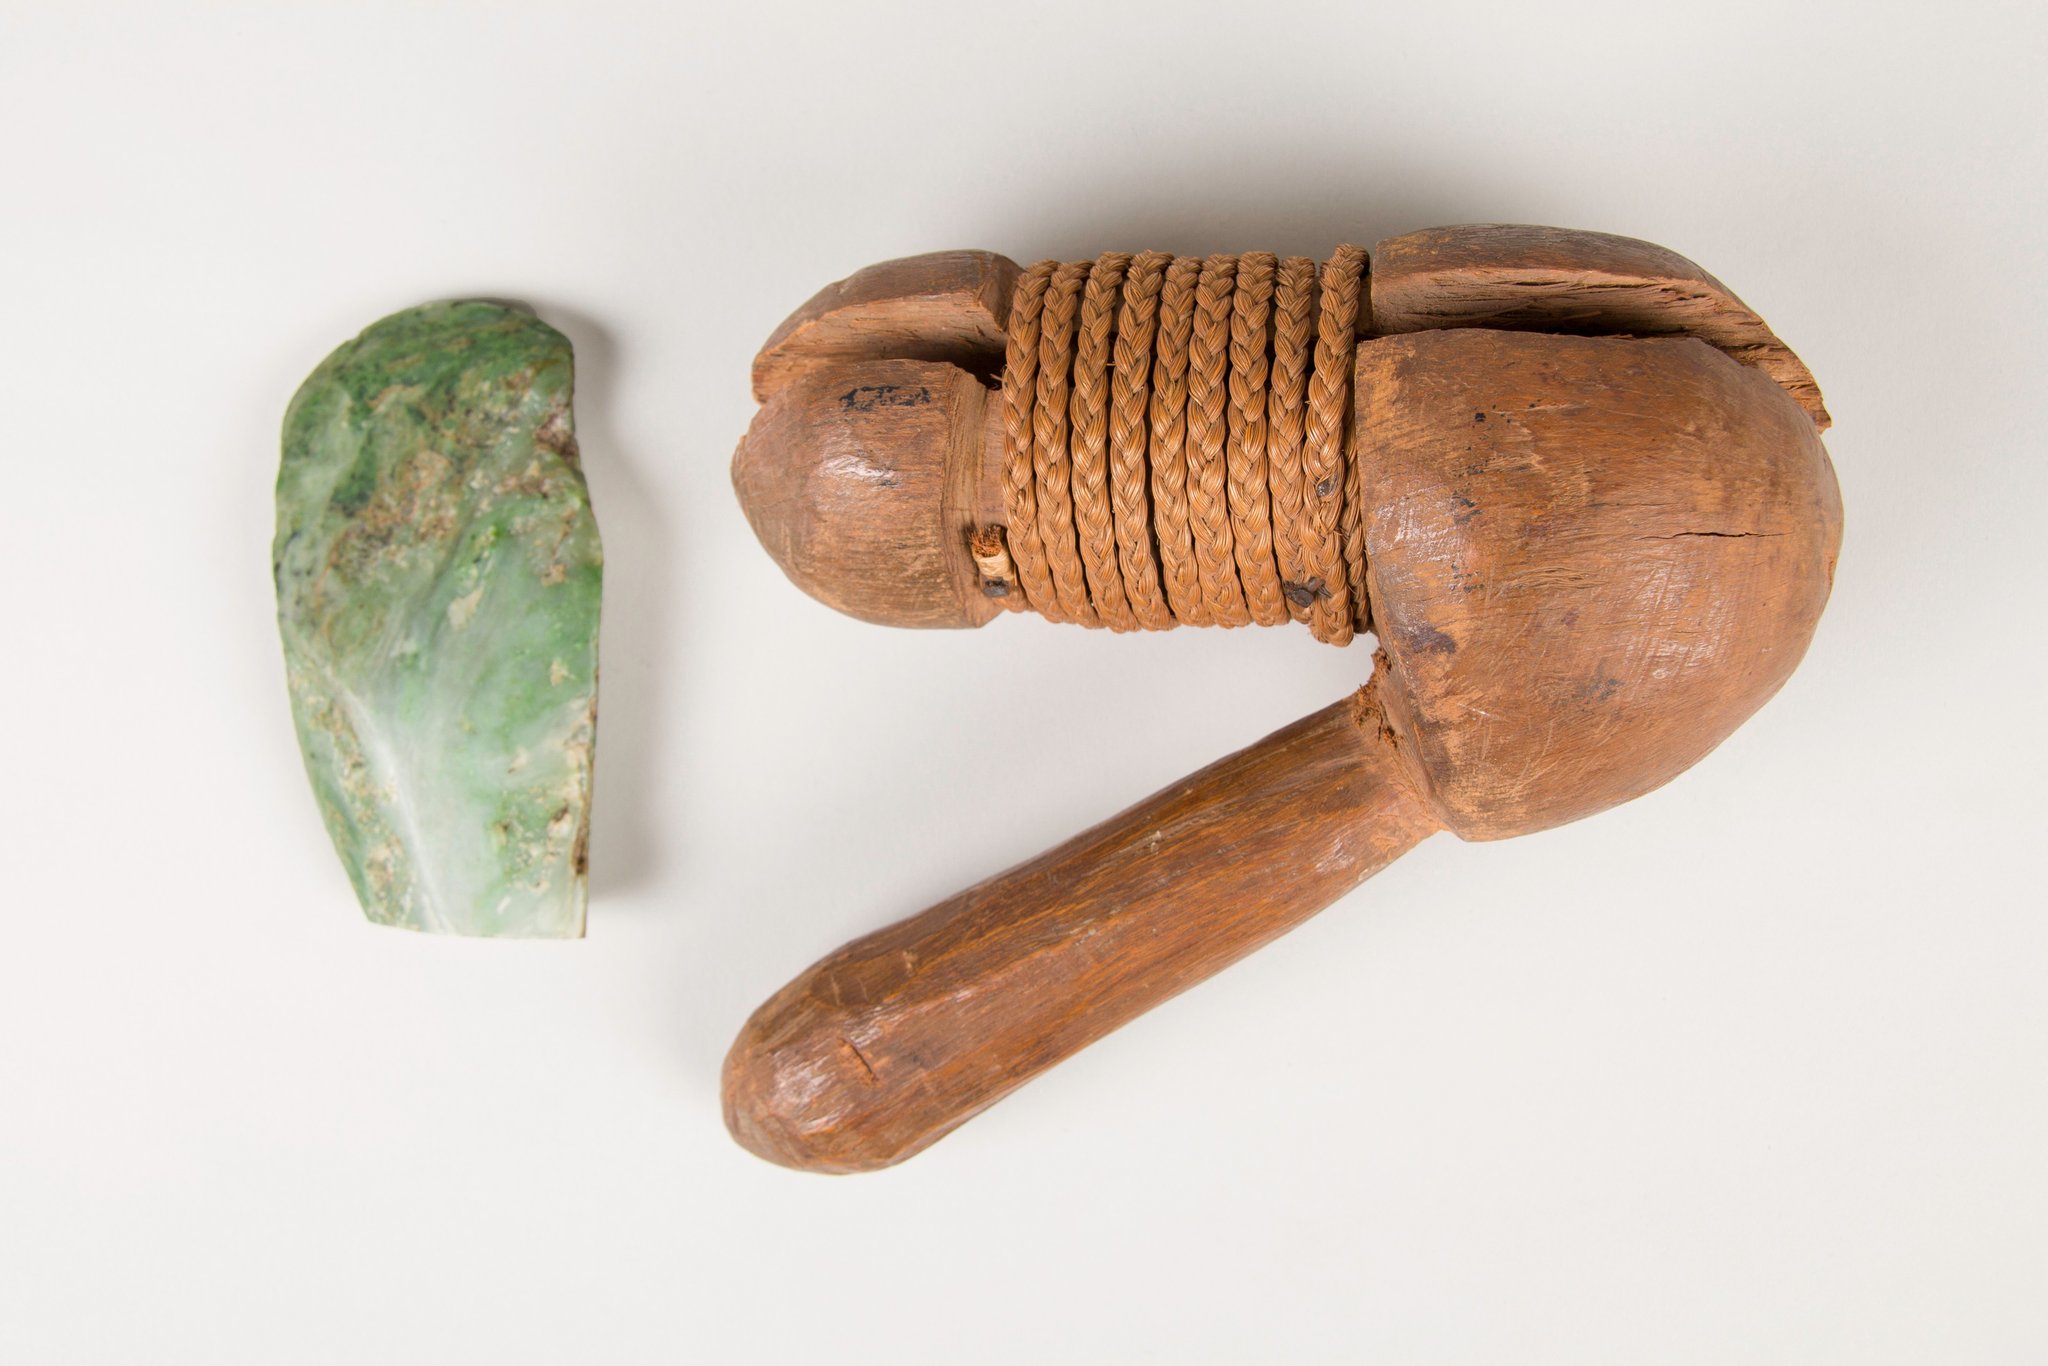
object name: adze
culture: new zealander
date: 1902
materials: jade